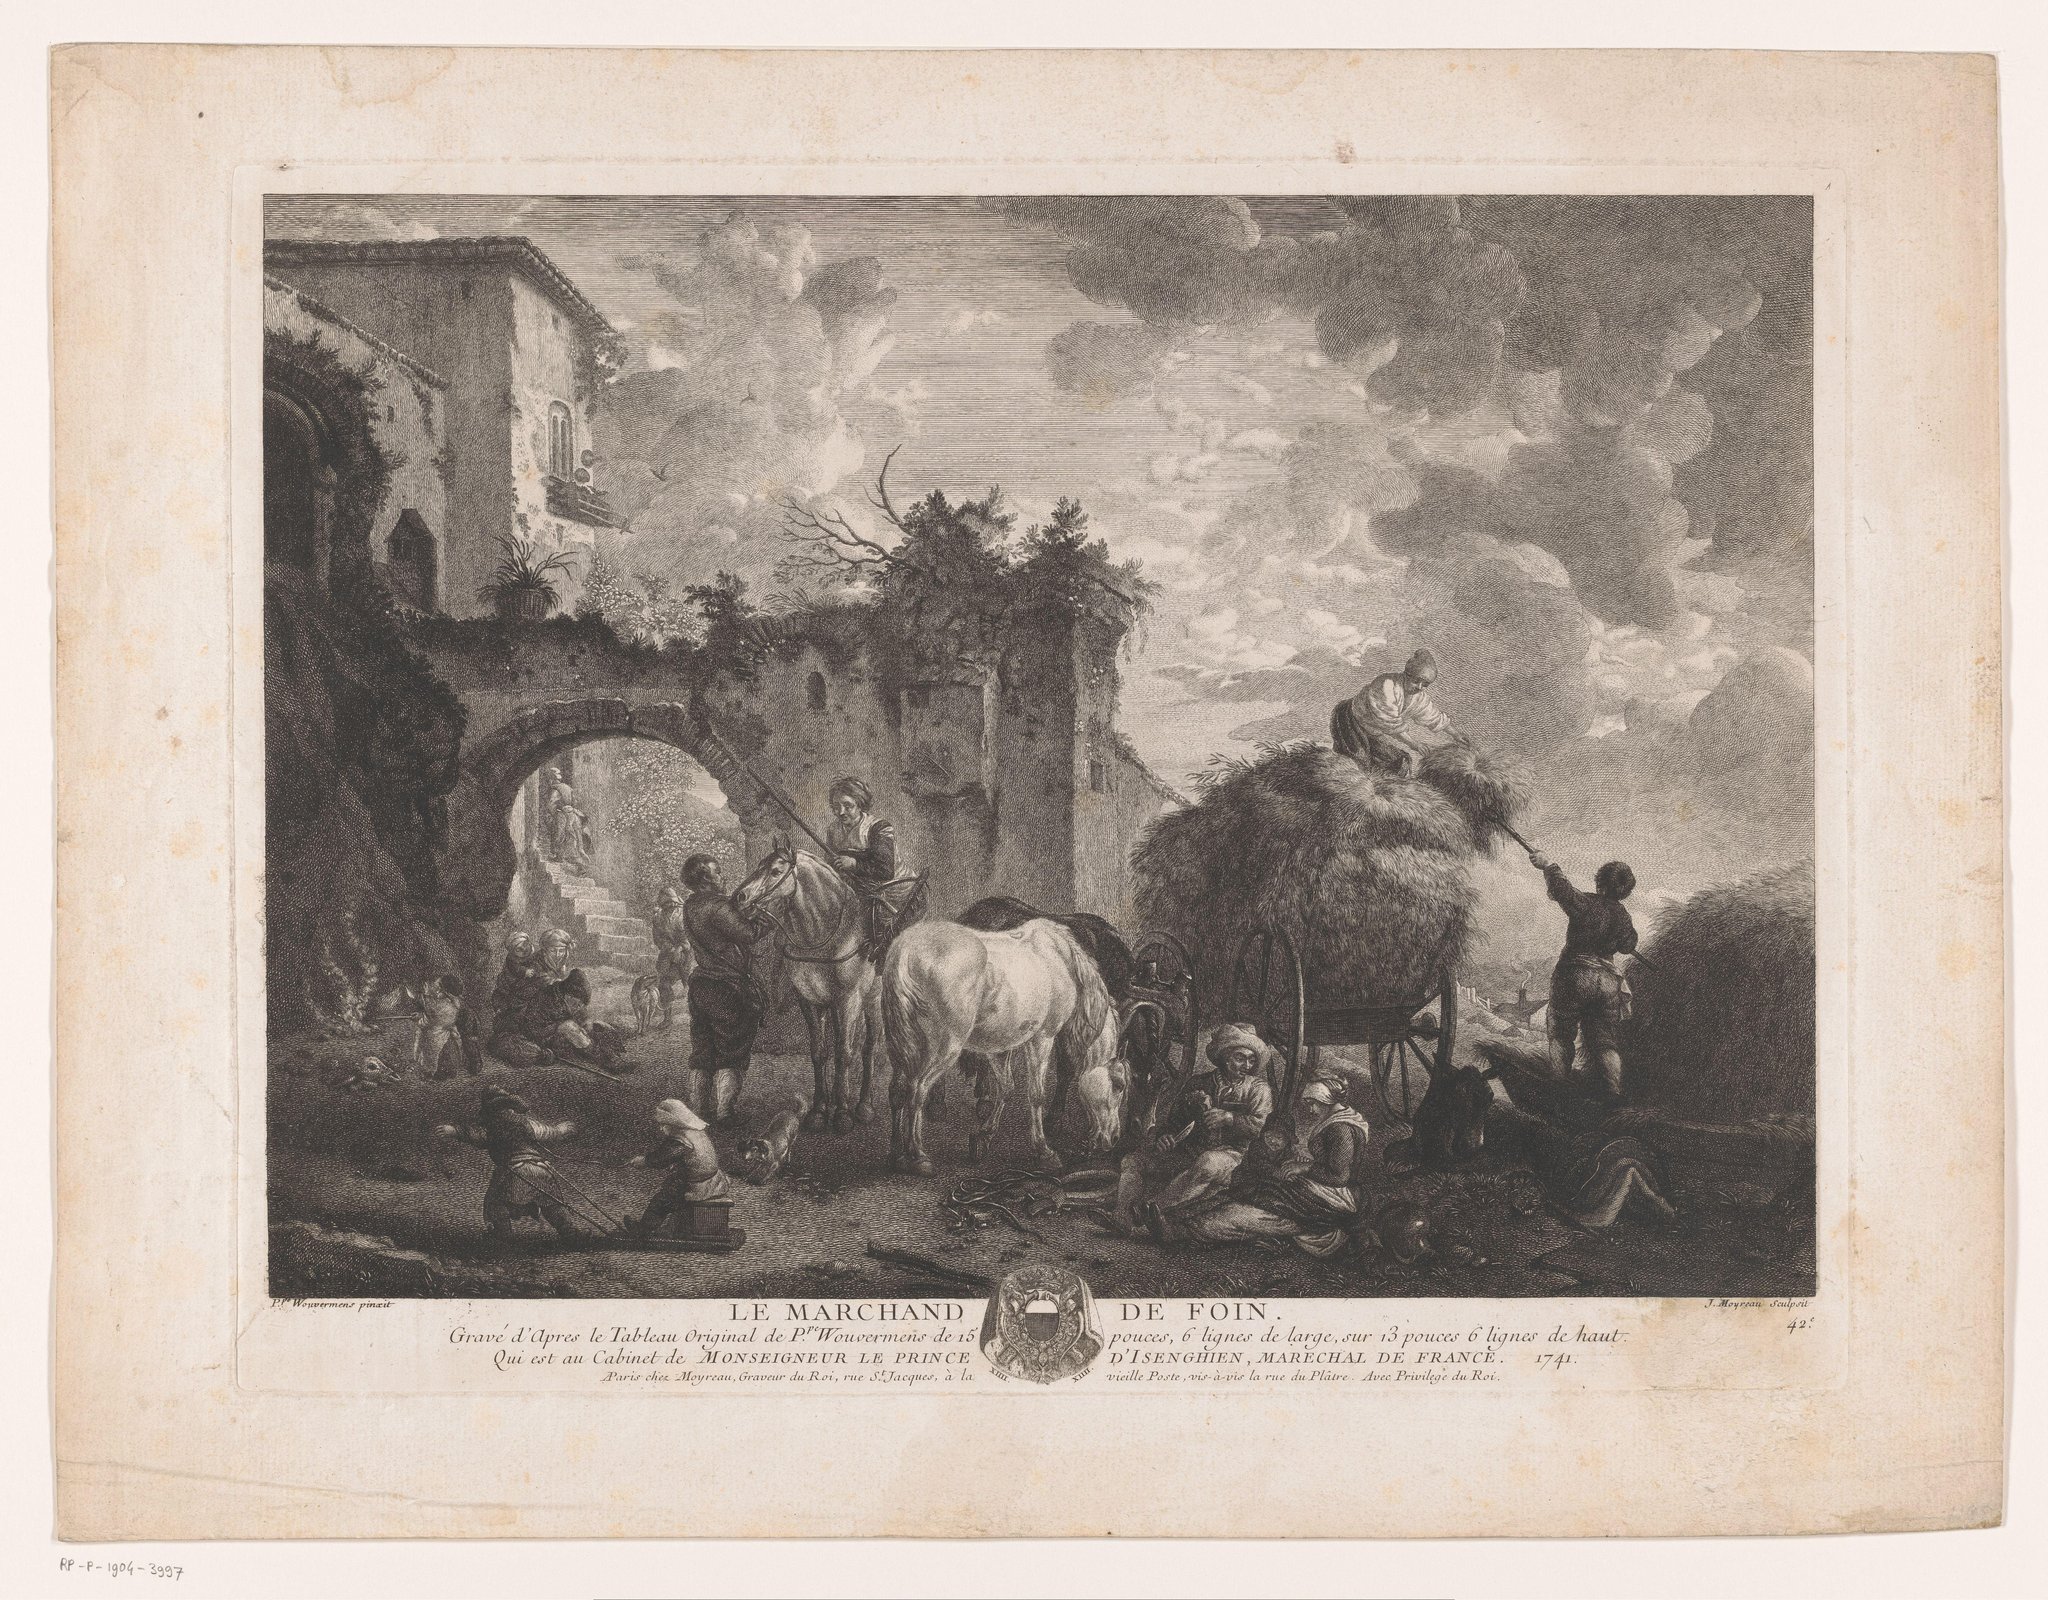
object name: print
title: Le marchand de foin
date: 1741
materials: paper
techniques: engraving, etching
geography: france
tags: horse, hay-wagon, merchant, salesman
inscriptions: collector's mark: Lugt 2228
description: Maakt deel uit van een serie van 89 prenten te dateren tussen ca. 1733-1762, naar het geschilderde oeuvre van Philips Wouwerman. Dit betreft plaat 42.